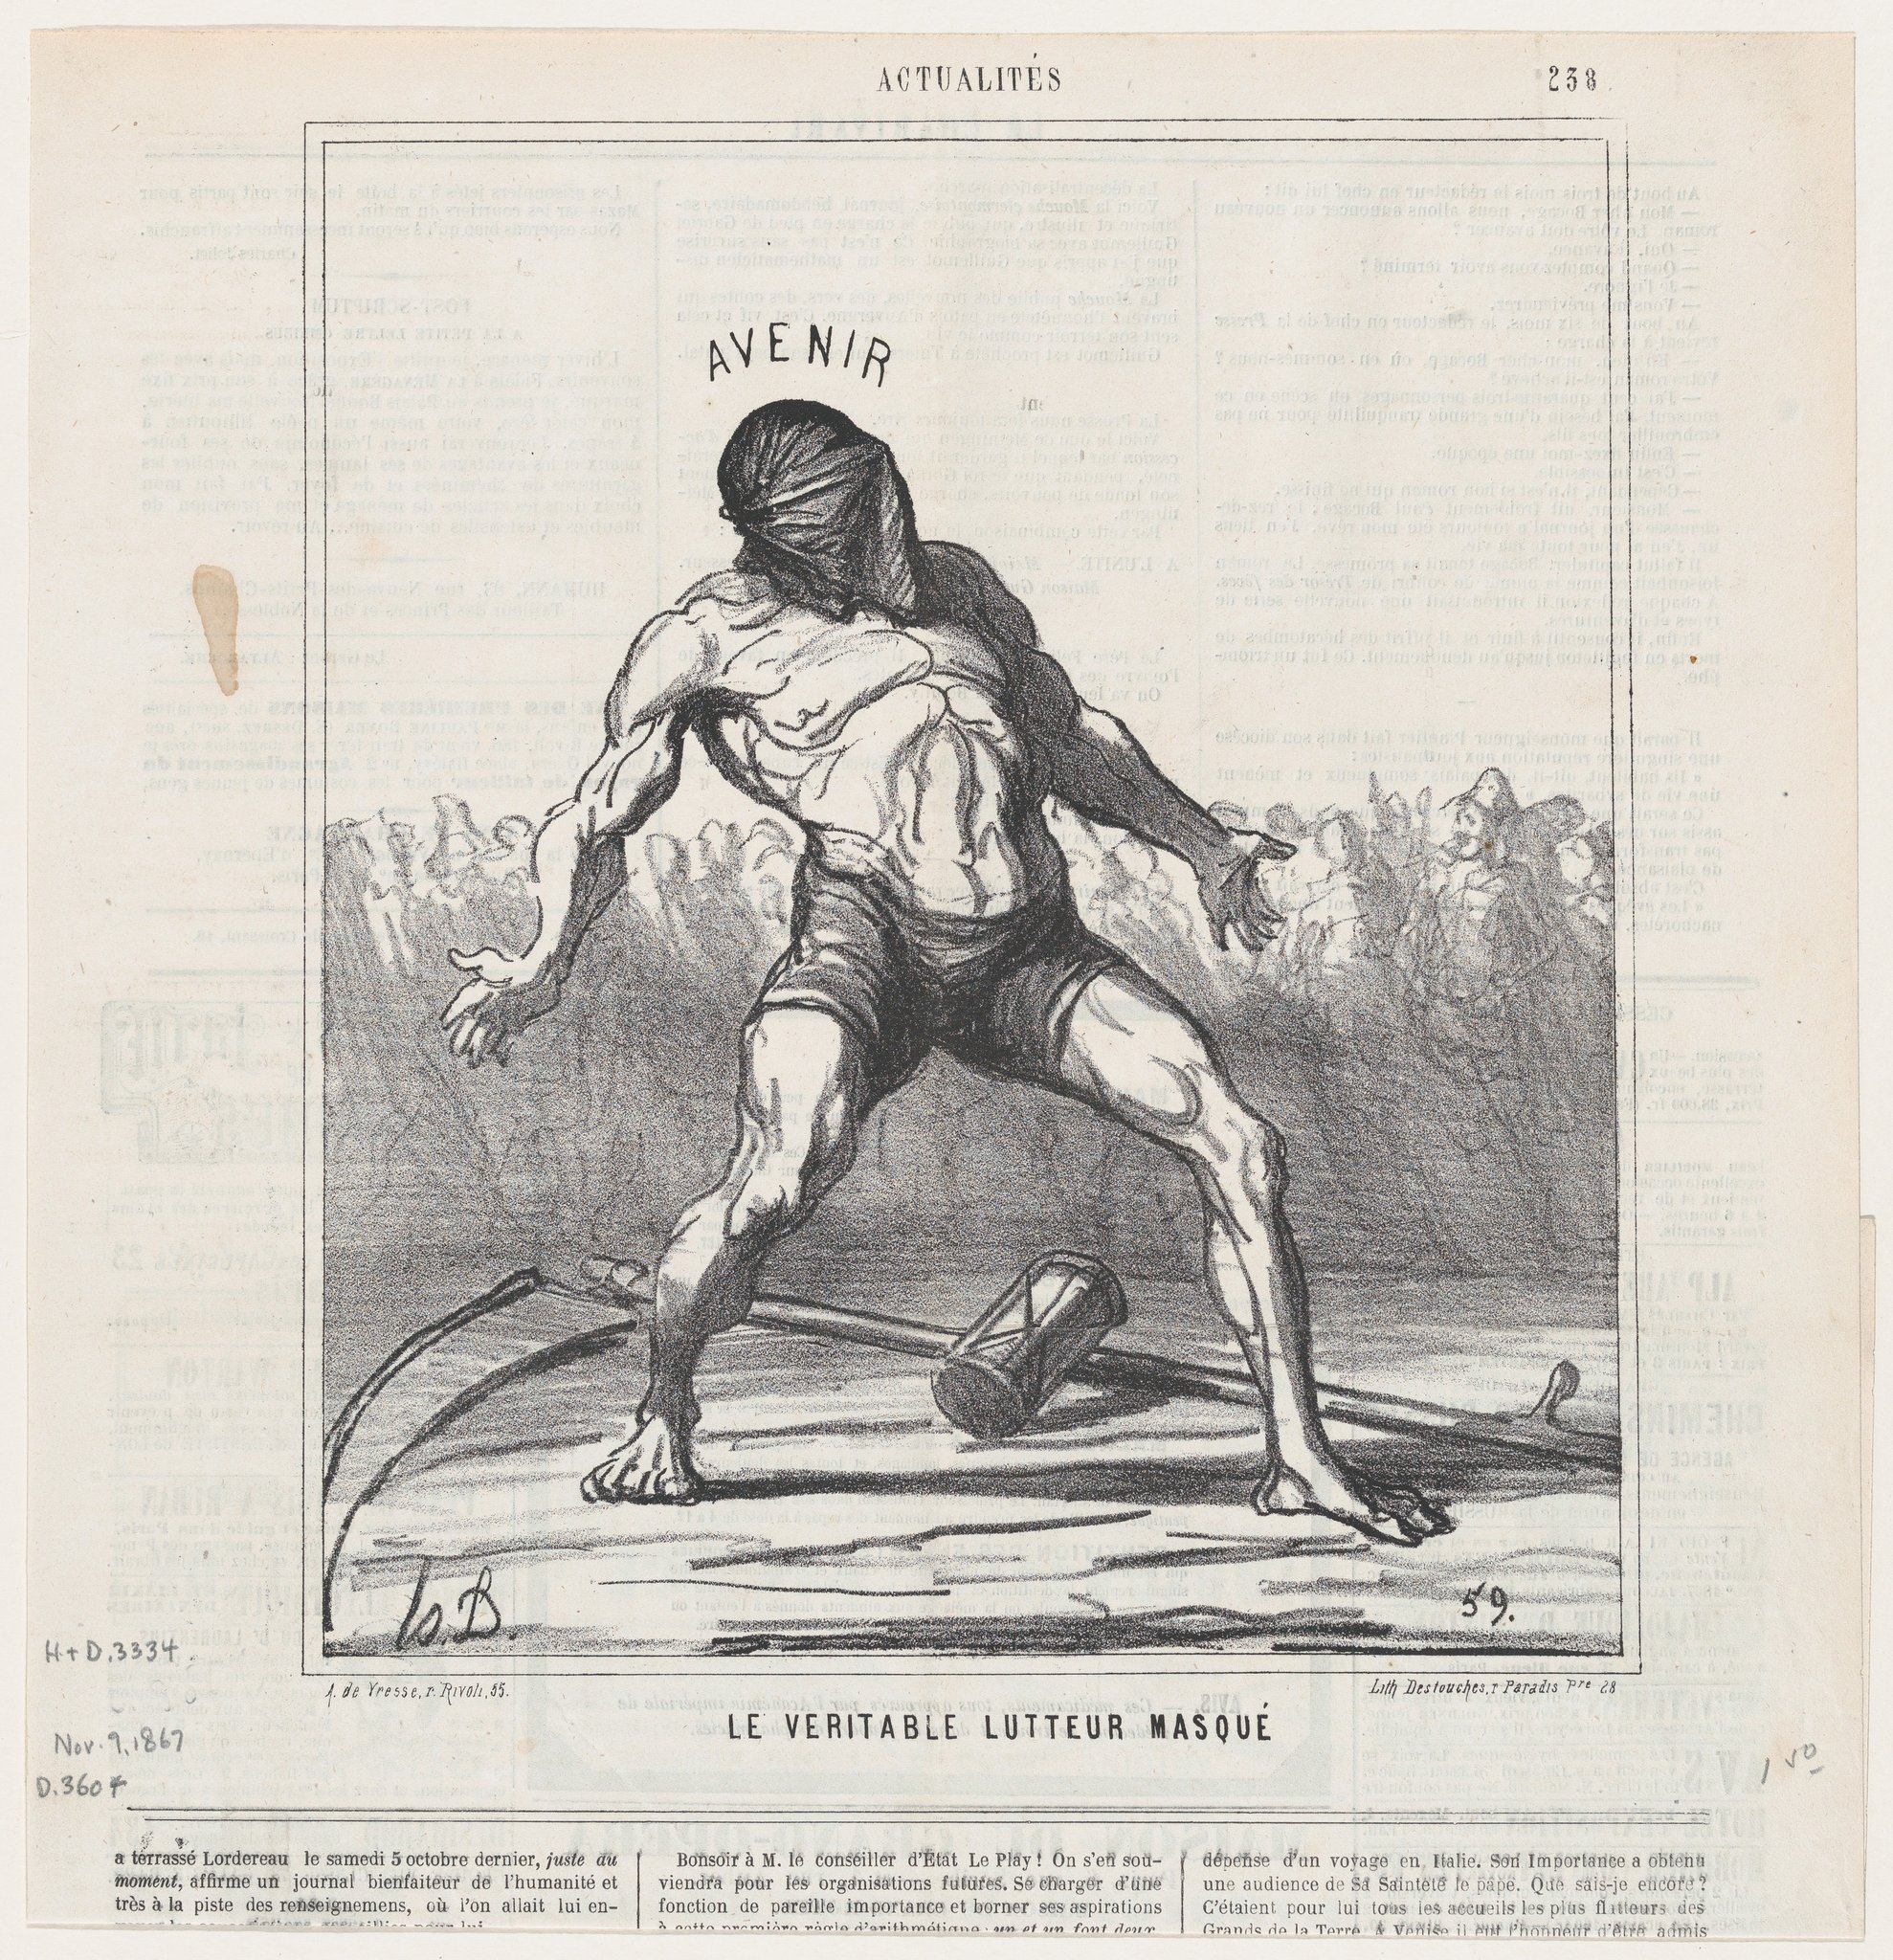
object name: print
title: The real masked fighter, from 'News of the day,' published in Le Charivari, November 9, 1867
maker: honoré daumier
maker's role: artist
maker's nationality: french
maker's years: 1808-1879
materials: paper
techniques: lithograph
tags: masks,men